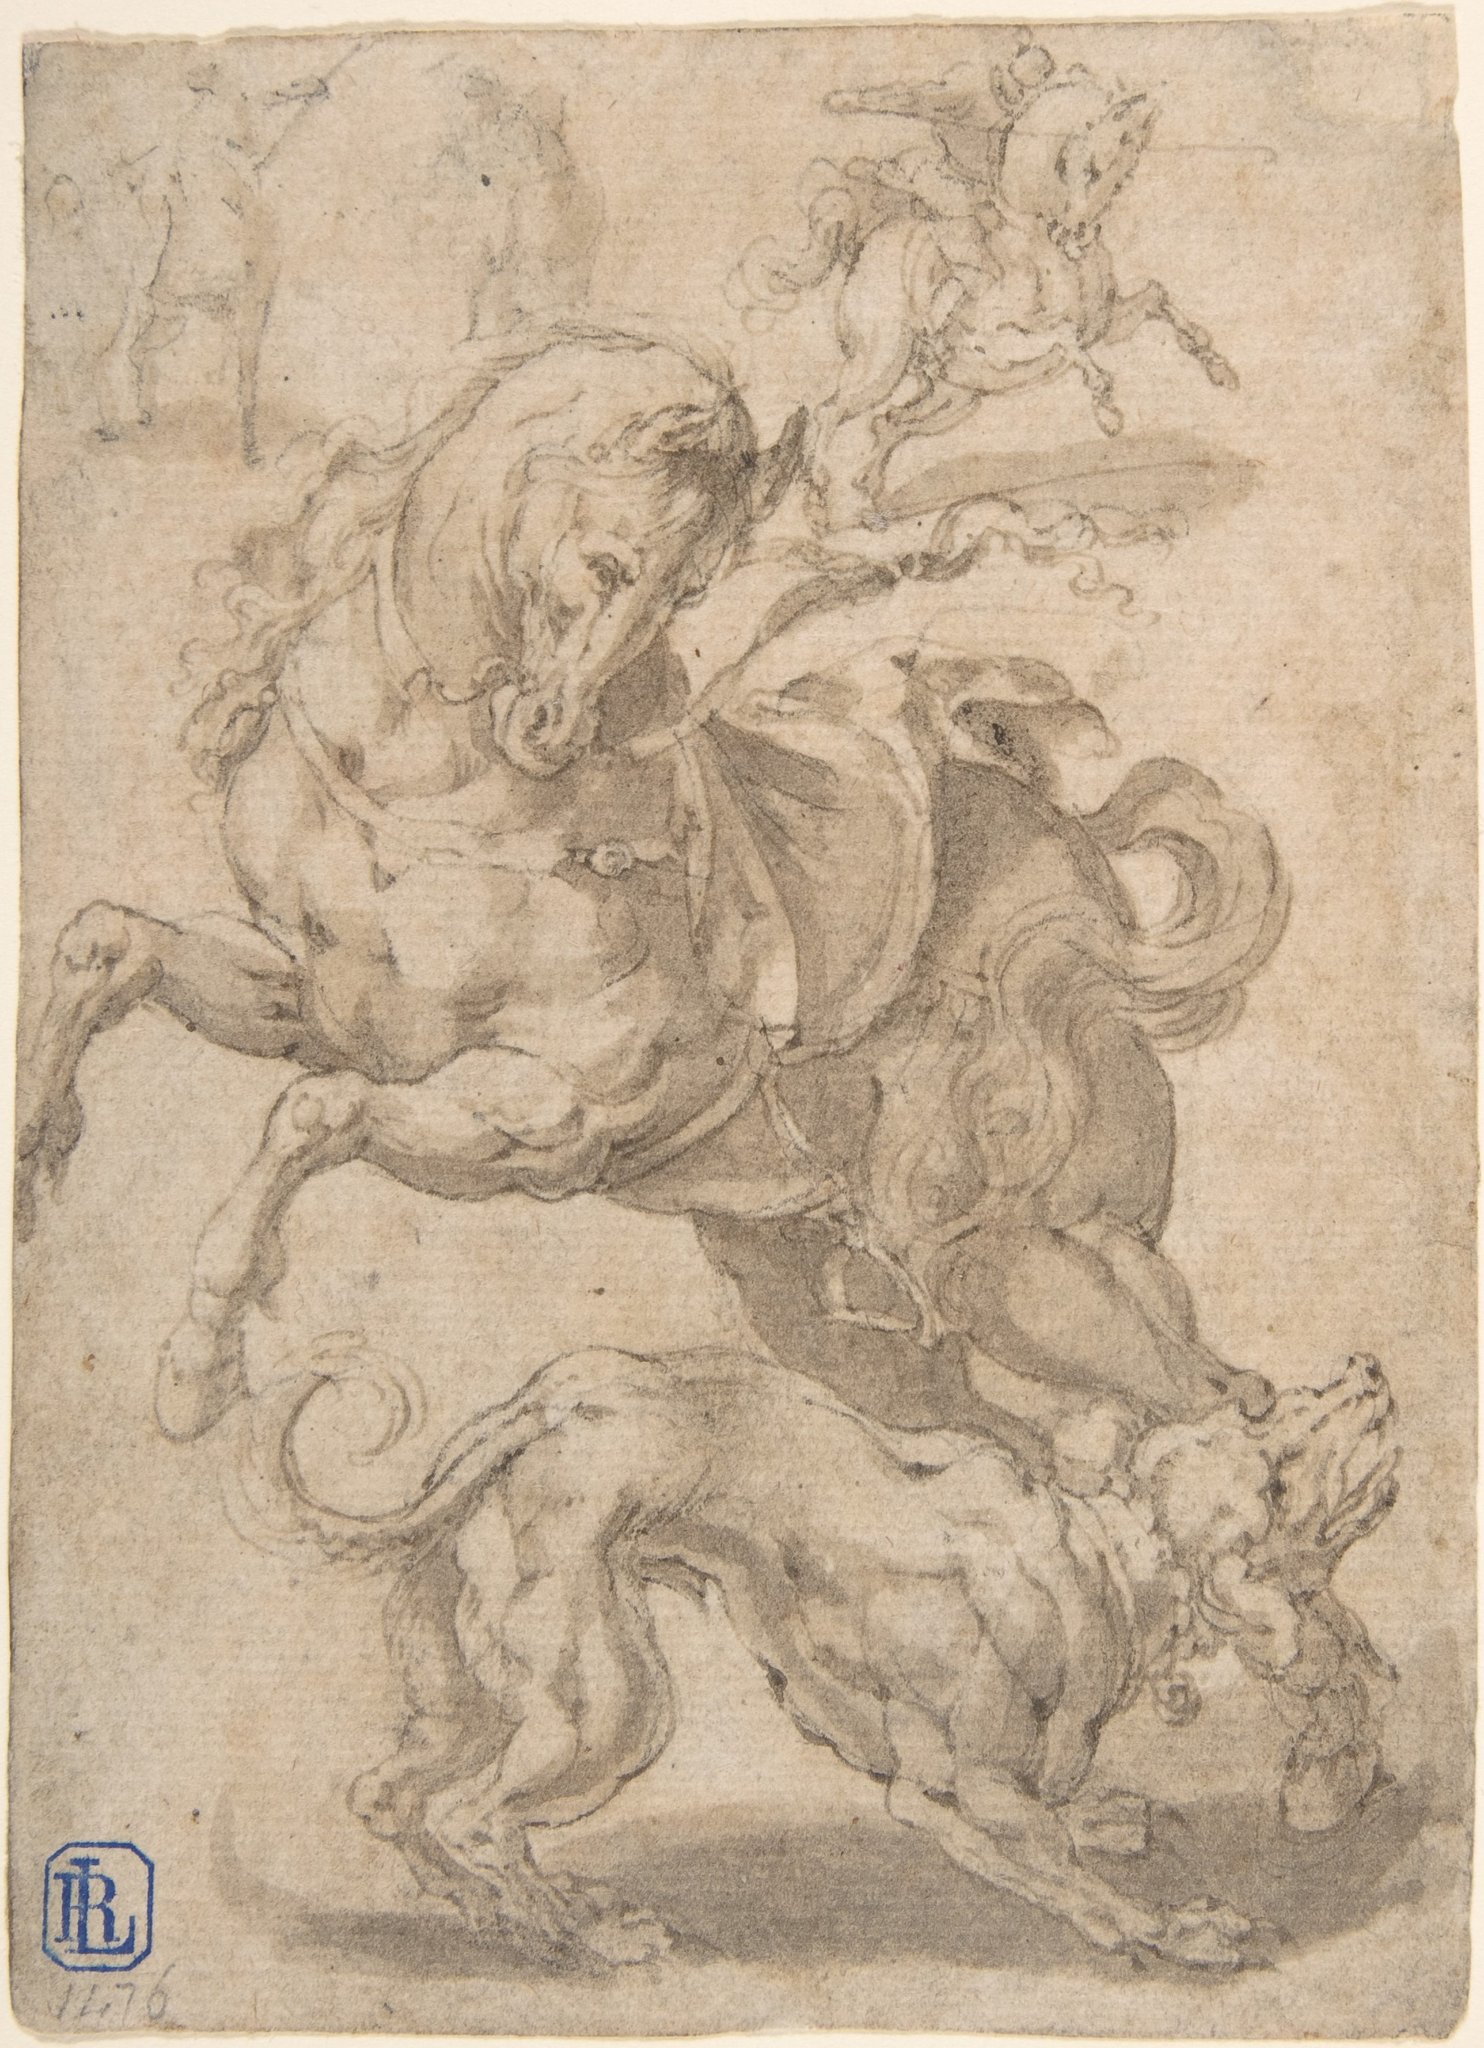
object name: drawing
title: Horses and Dog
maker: anonymous, 17th century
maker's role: artist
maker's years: 1600-1700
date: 1601-1700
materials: ink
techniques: brush, pen, wash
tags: dogs,horses